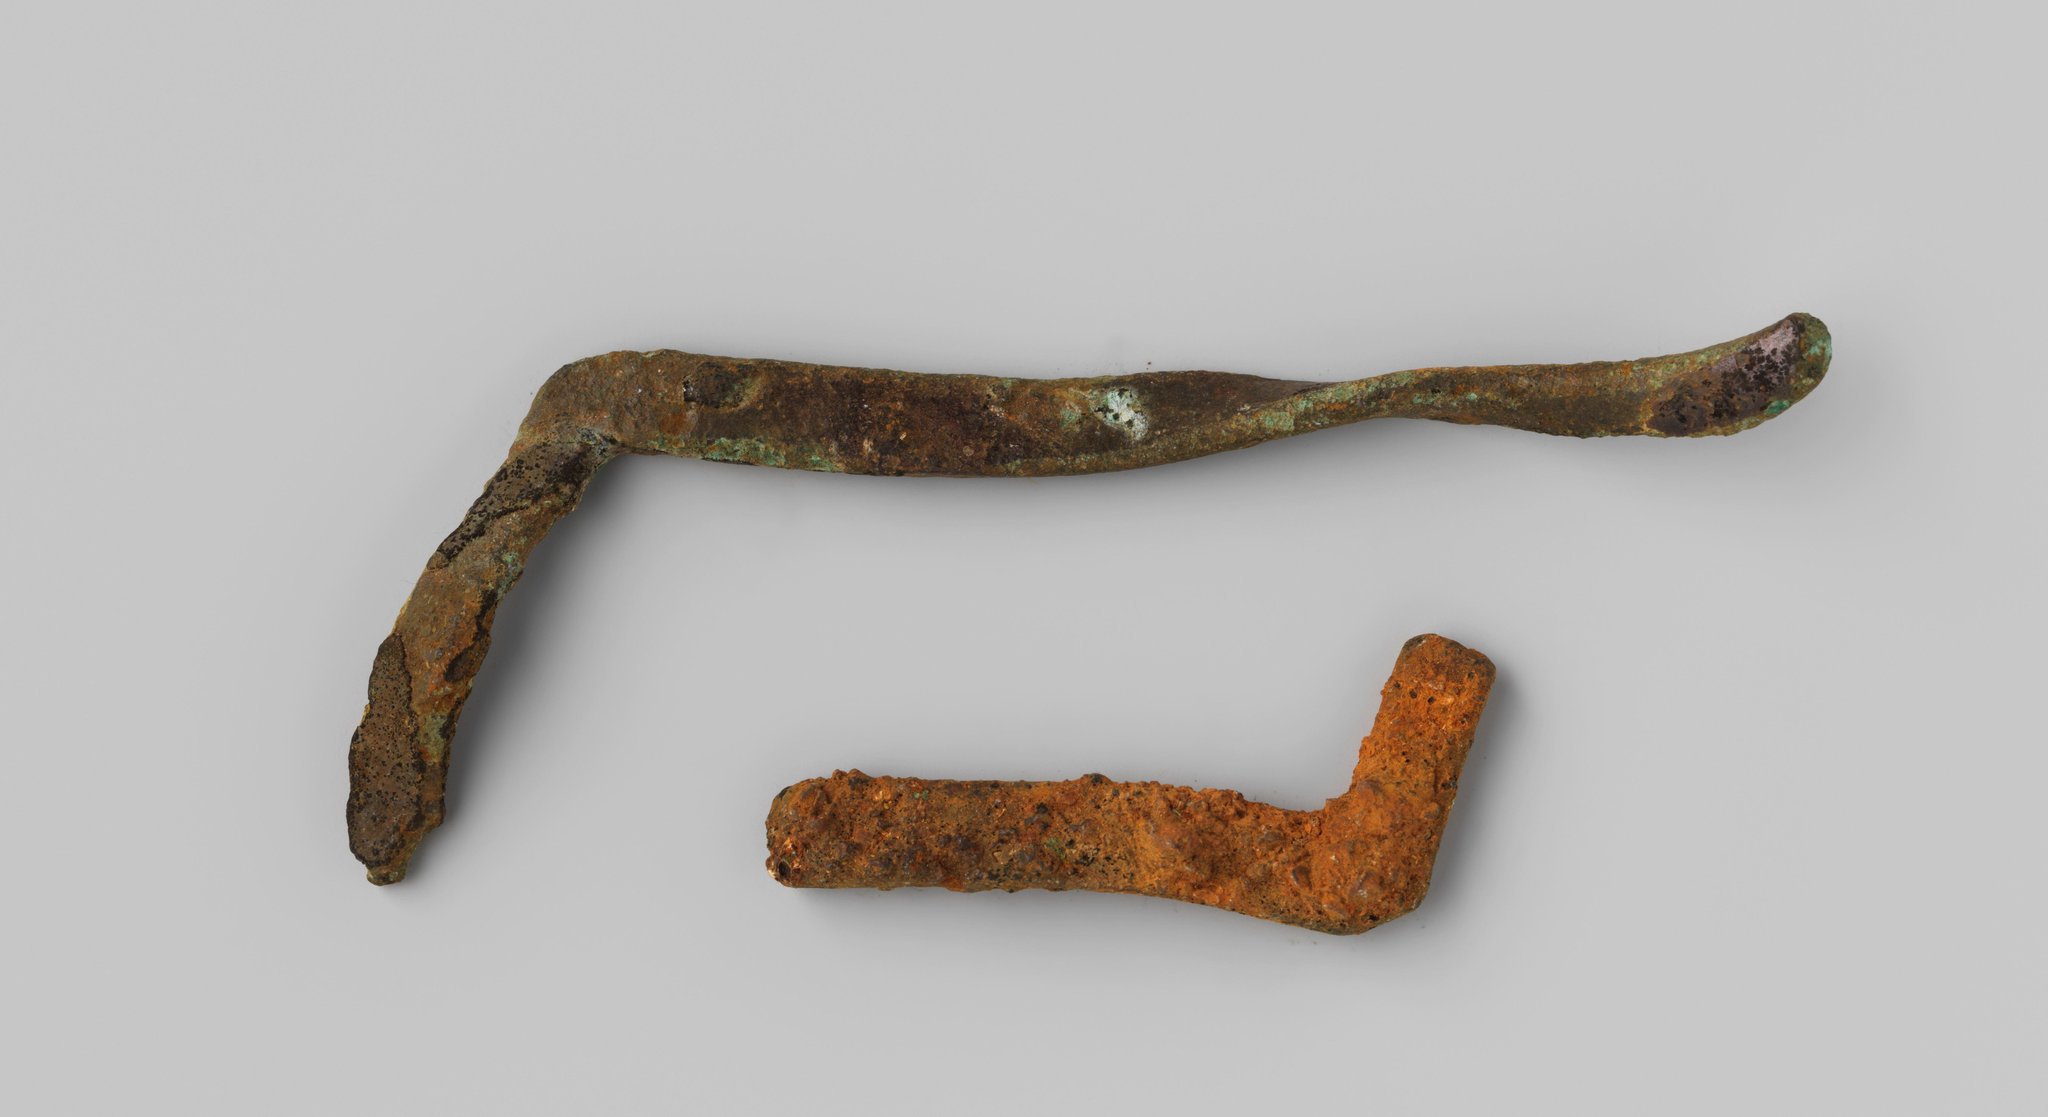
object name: belt buckle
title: Fragmenten van riemgespen uit het wrak van de Oost-Indiëvaarder Hollandia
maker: Anonymous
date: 1700-1743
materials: copper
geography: netherlands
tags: verenigde oostindische compagnie, hollandia (schip), annet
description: Rectangular, fragm of rings, id. NG 1980-27H2852, belt buckle.